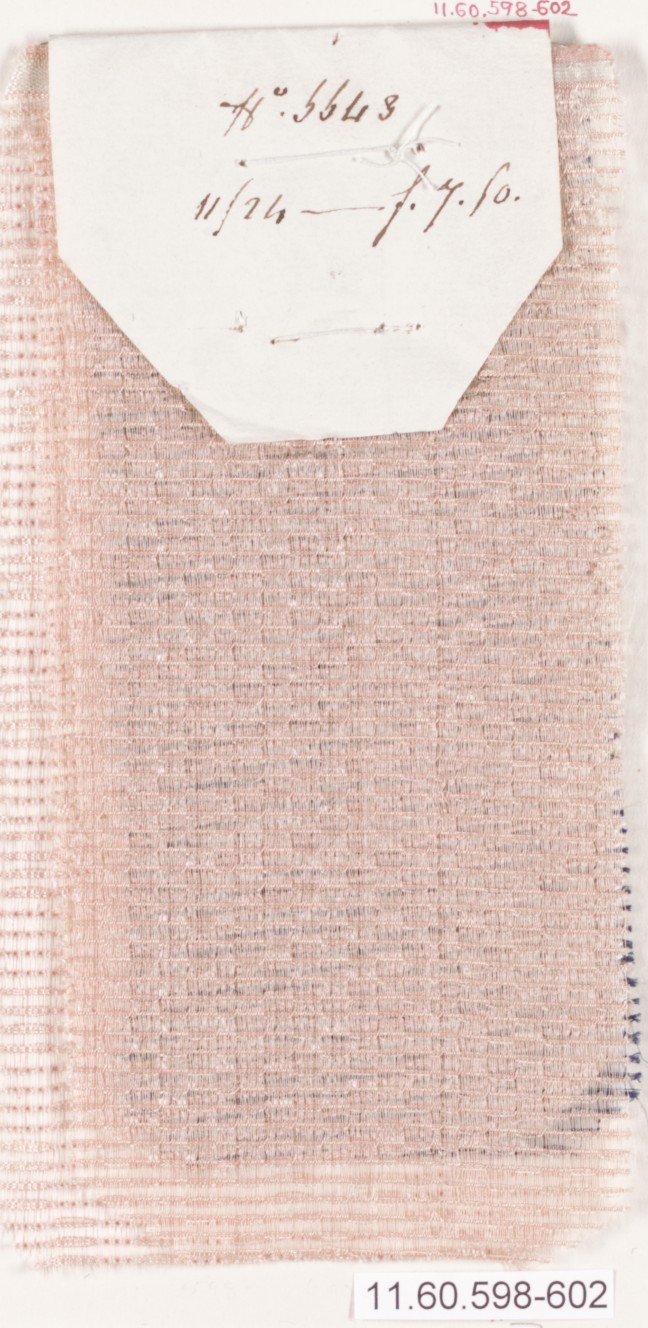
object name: sample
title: Samples (5)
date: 1801-1833